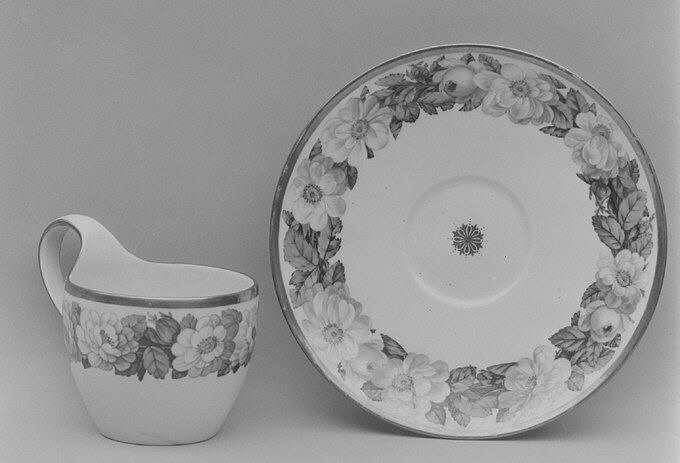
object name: cup and saucer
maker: royal porcelain manufactory, berlin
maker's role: manufactory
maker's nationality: german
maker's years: 1763-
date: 1803-1810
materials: hard paste porcelain